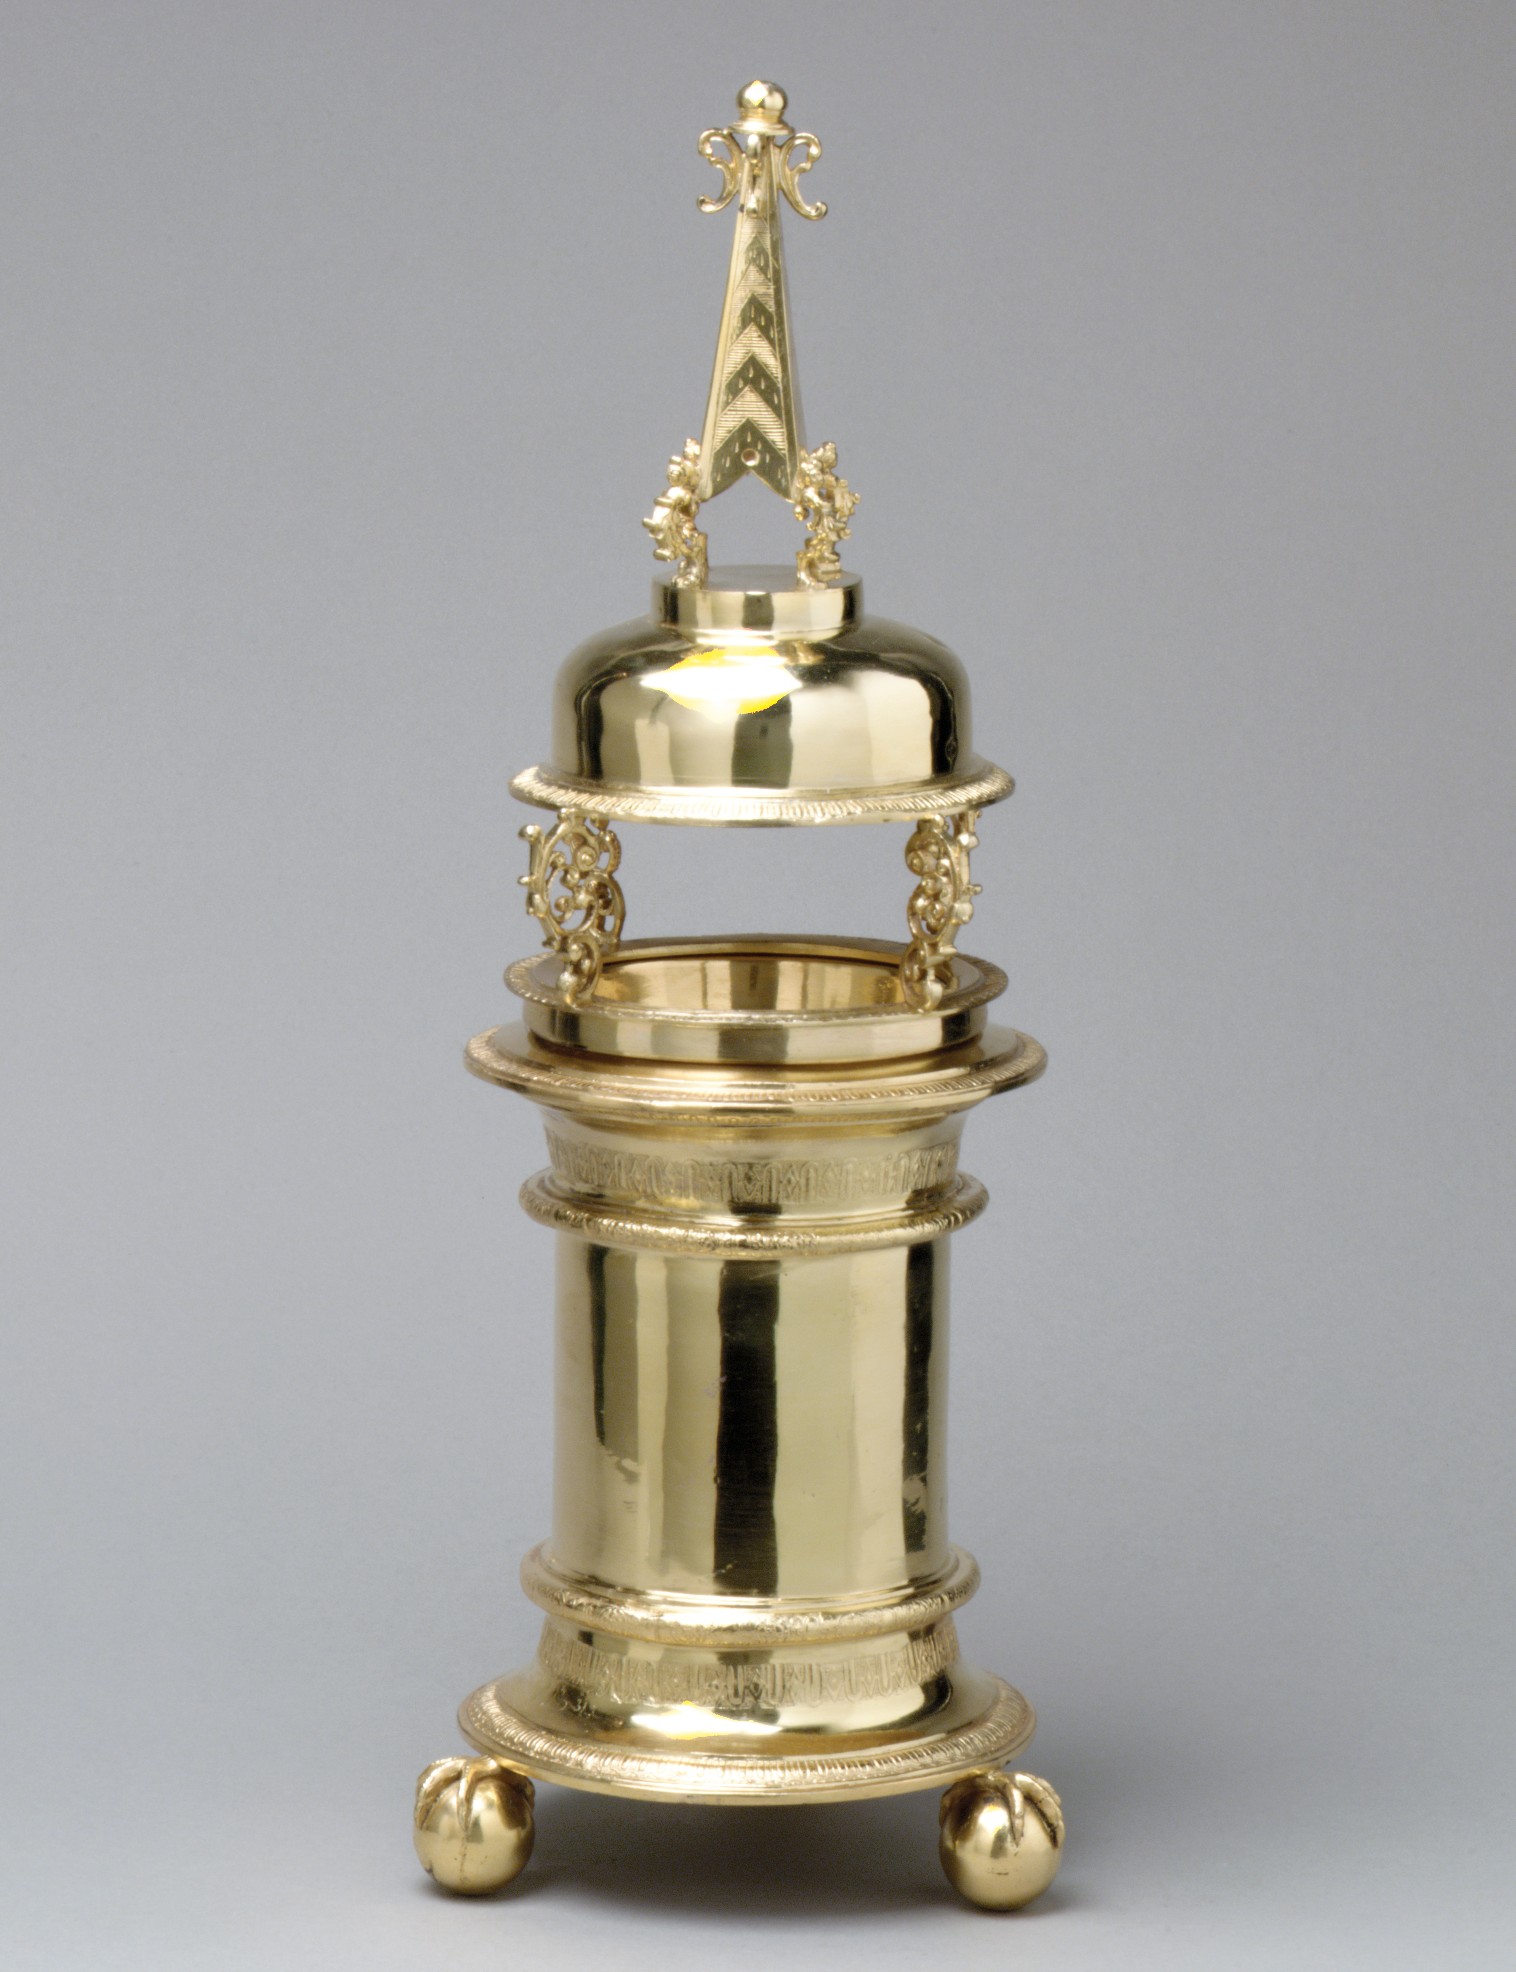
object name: salt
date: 1801-1900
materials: metal, silver